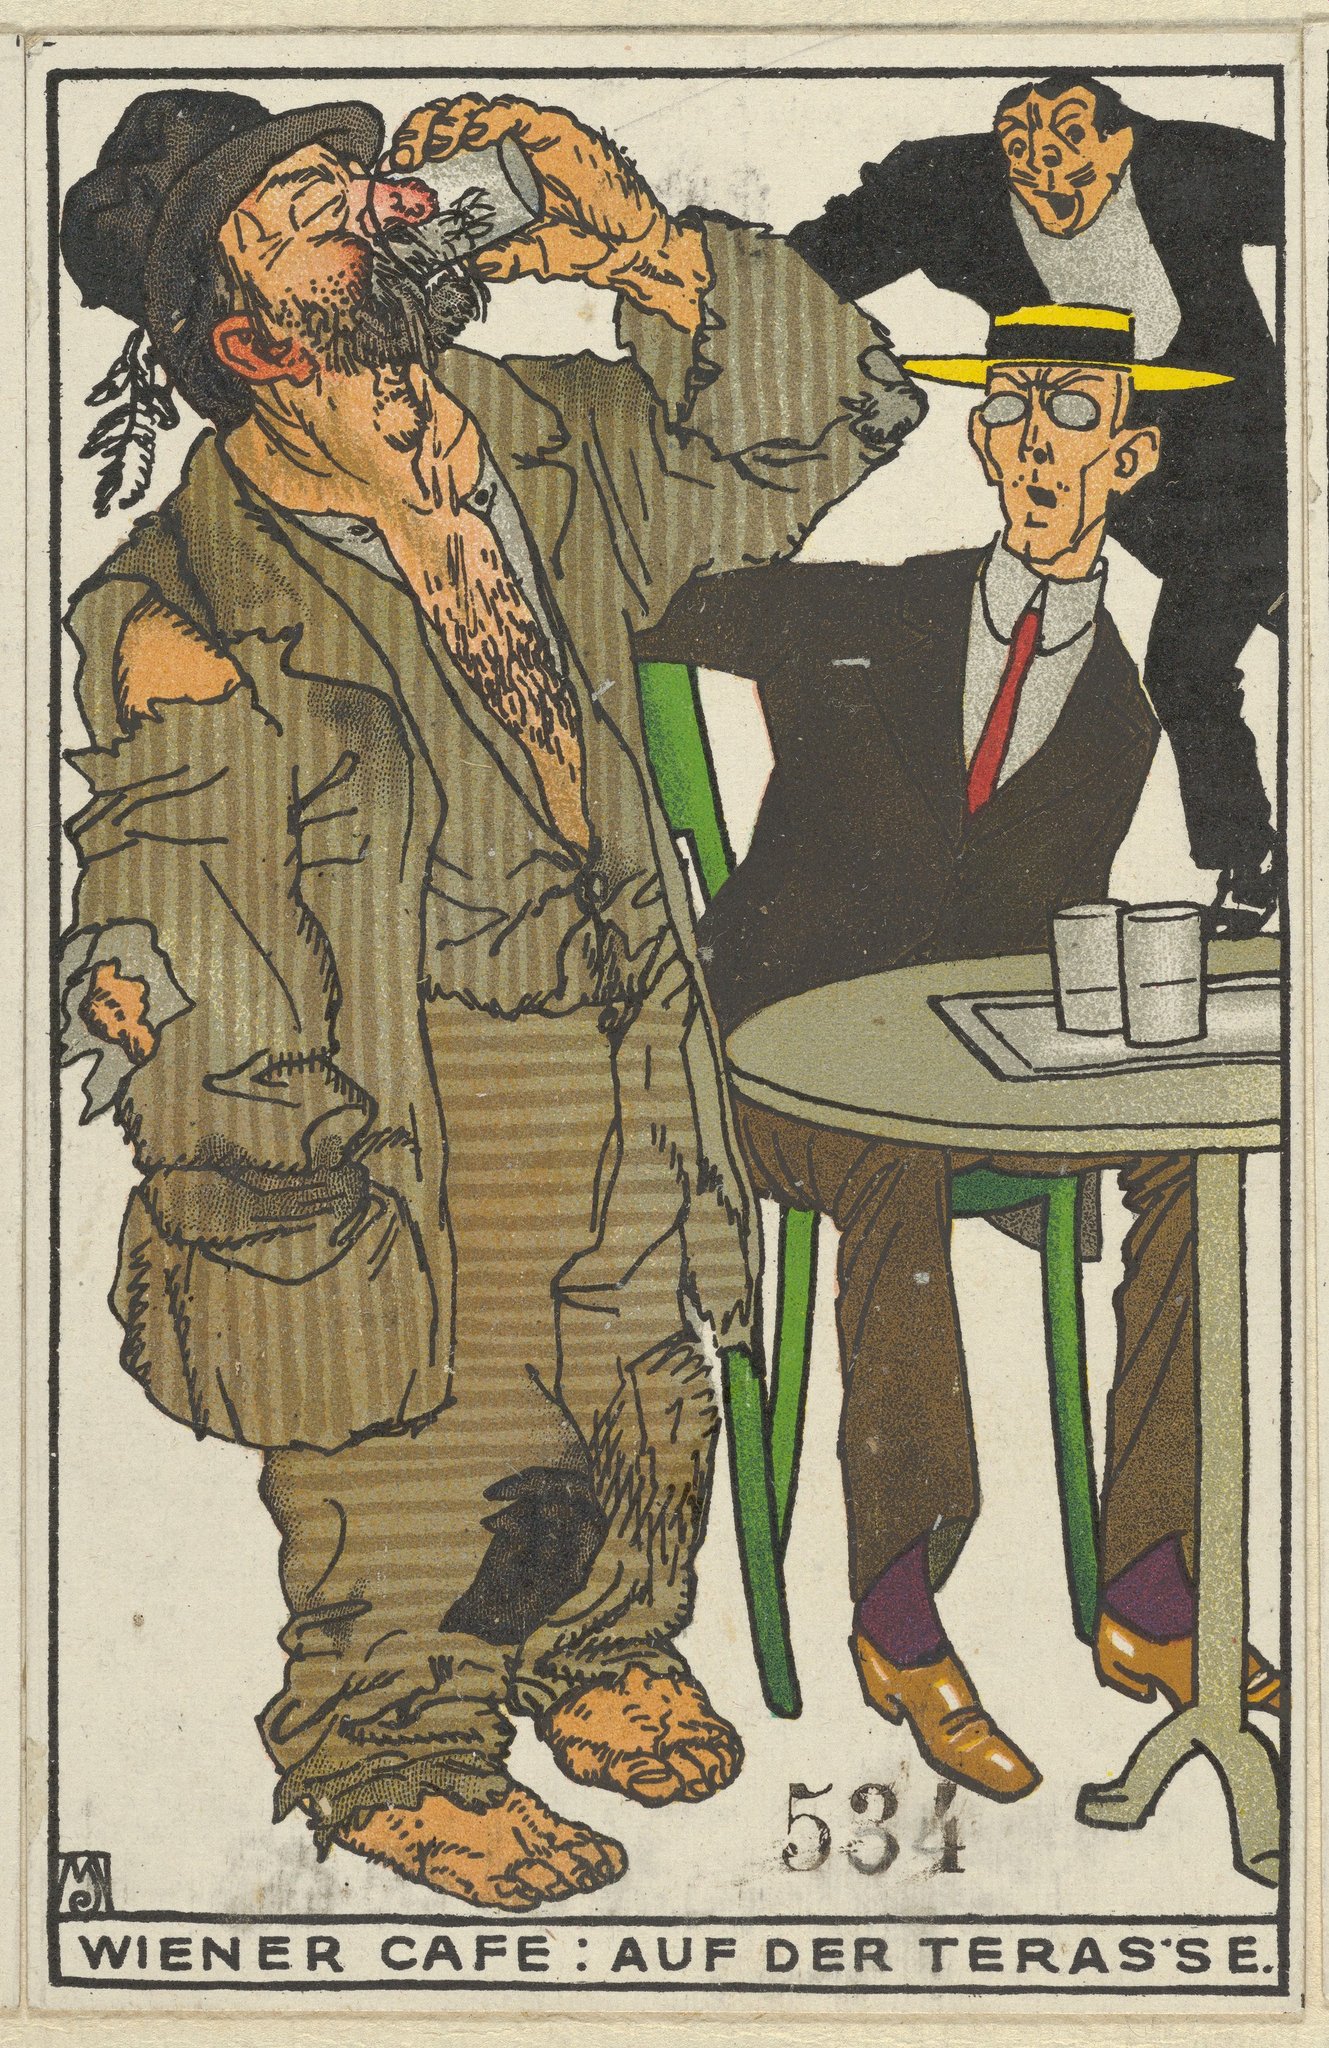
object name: print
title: Viennese Café: On the Terrace (Wiener Café: Auf der Terasse)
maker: moriz jung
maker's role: artist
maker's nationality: austrian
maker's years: 1885-1915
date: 1911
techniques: lithograph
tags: men,drinking